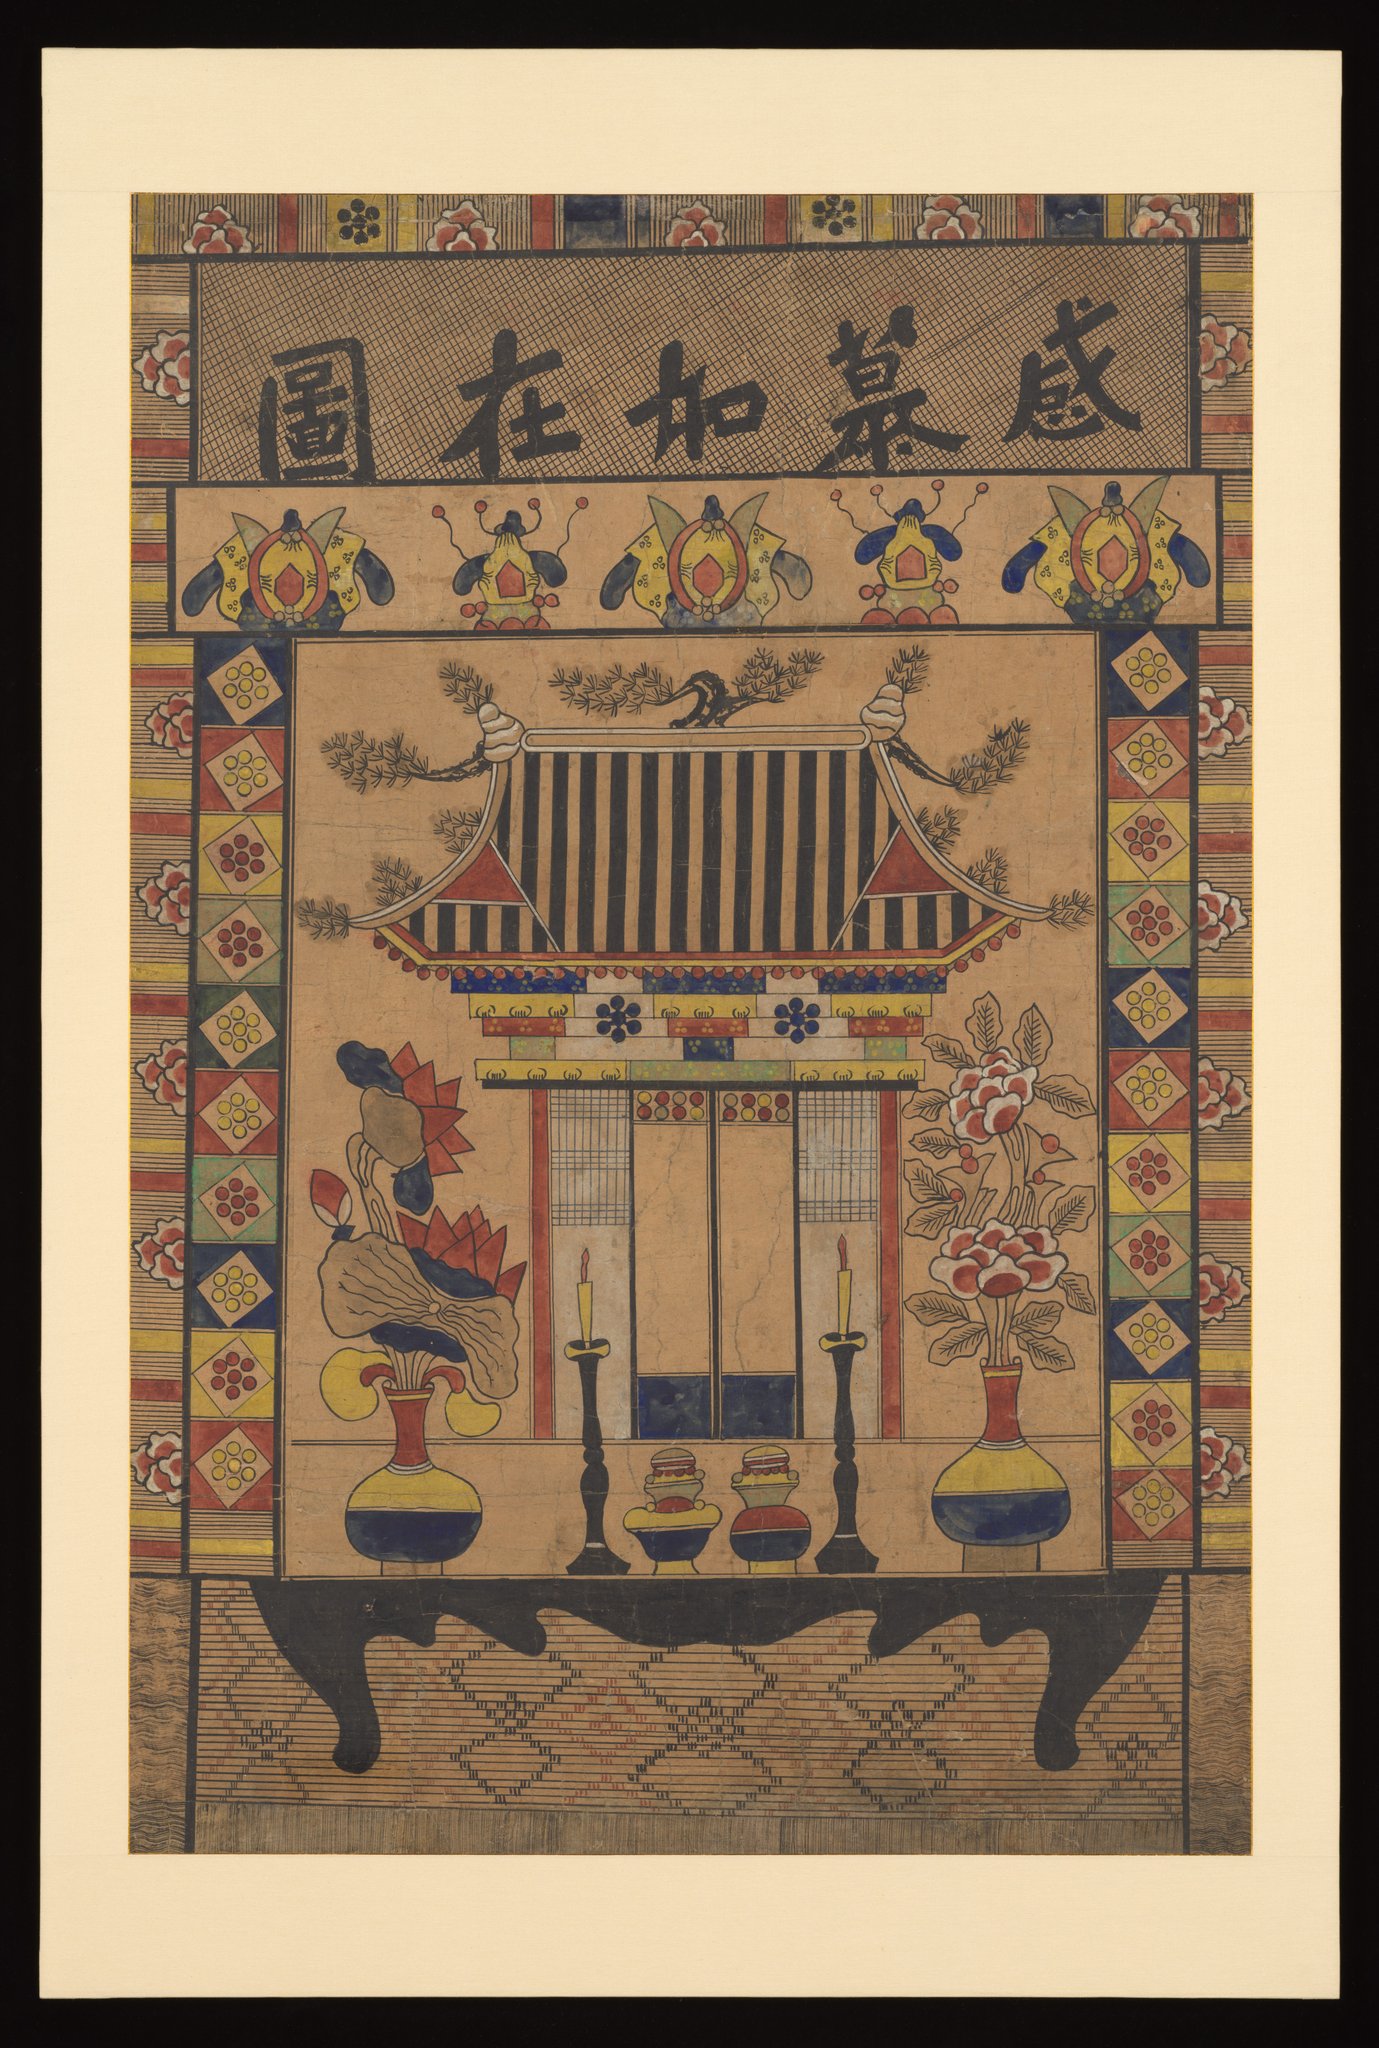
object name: painting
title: Ancestral shrine painting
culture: korean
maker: unidentified artist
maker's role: artist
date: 1801-1900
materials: ink, paper